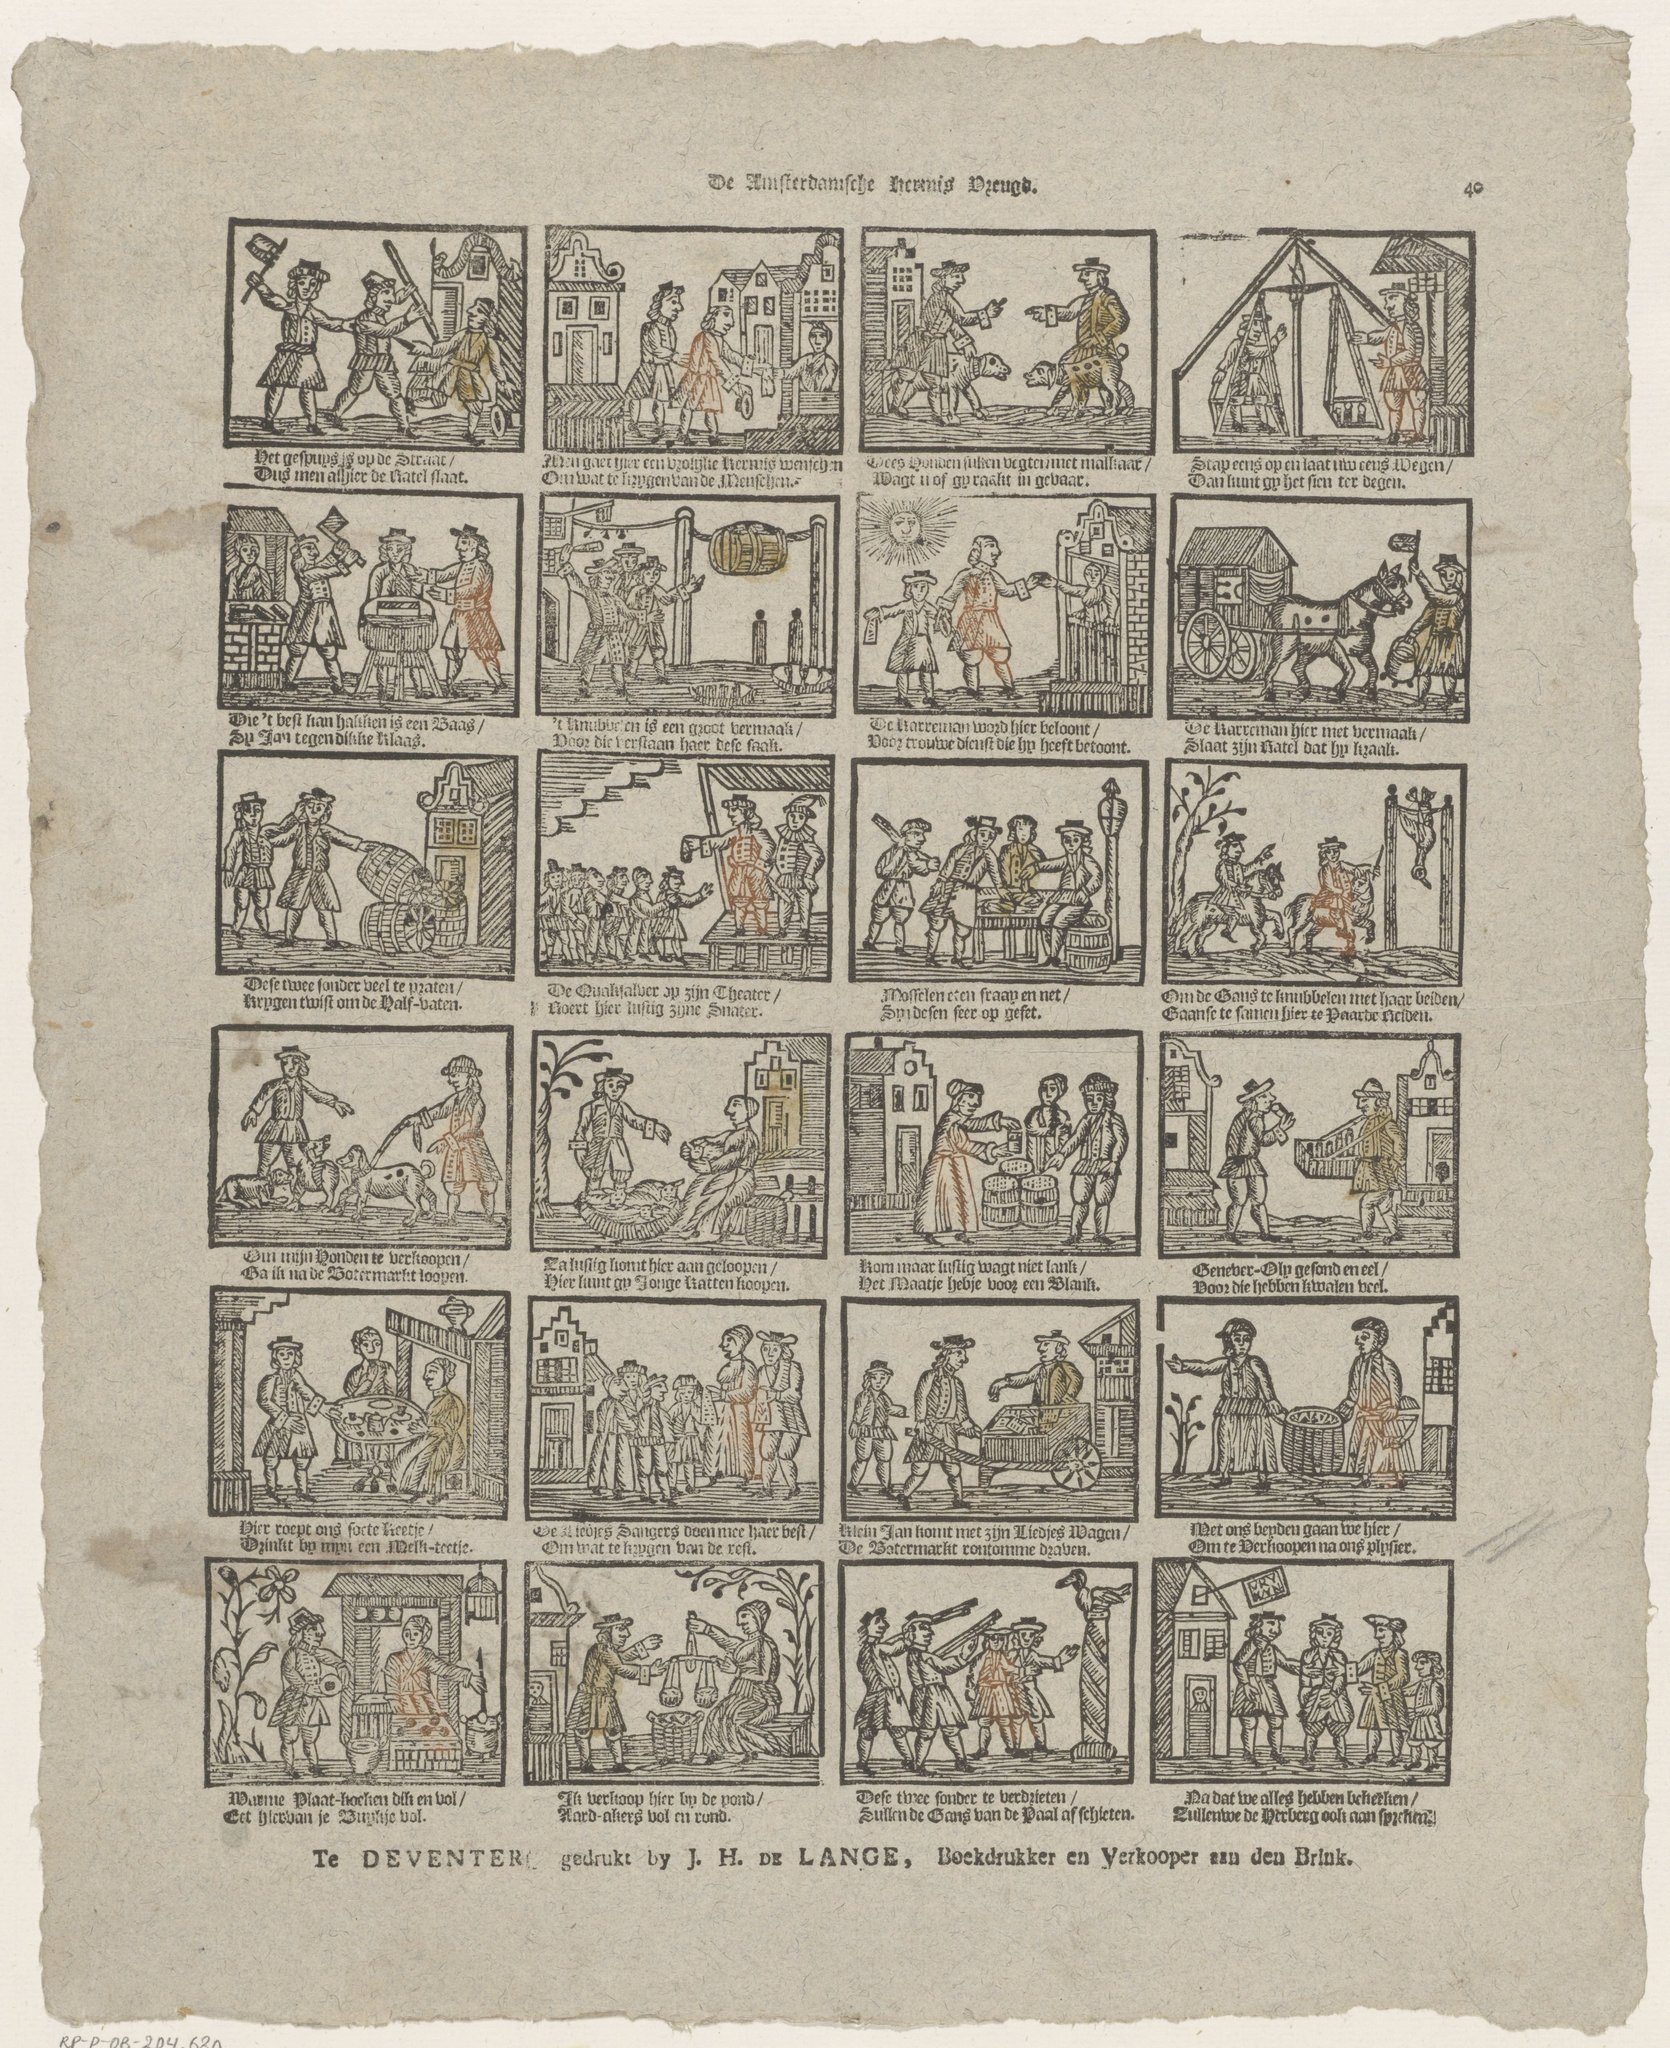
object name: popular print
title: Kinders hier hebt gy tot u playsier / Van Jan en Lijs op 't ys vol zwier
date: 1787-1822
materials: paper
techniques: colour, letterpress printing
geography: deventer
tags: street-trader, pleasure fair and circus, amsterdam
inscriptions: inscription: ‘Bartel Badima’, collector's mark: Lugt 2760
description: Blad met 24 taferelen op de Amsterdamse kermis. Onder elke afbeelding een tweeregelig vers. Genummerd rechtsboven: No. 40.